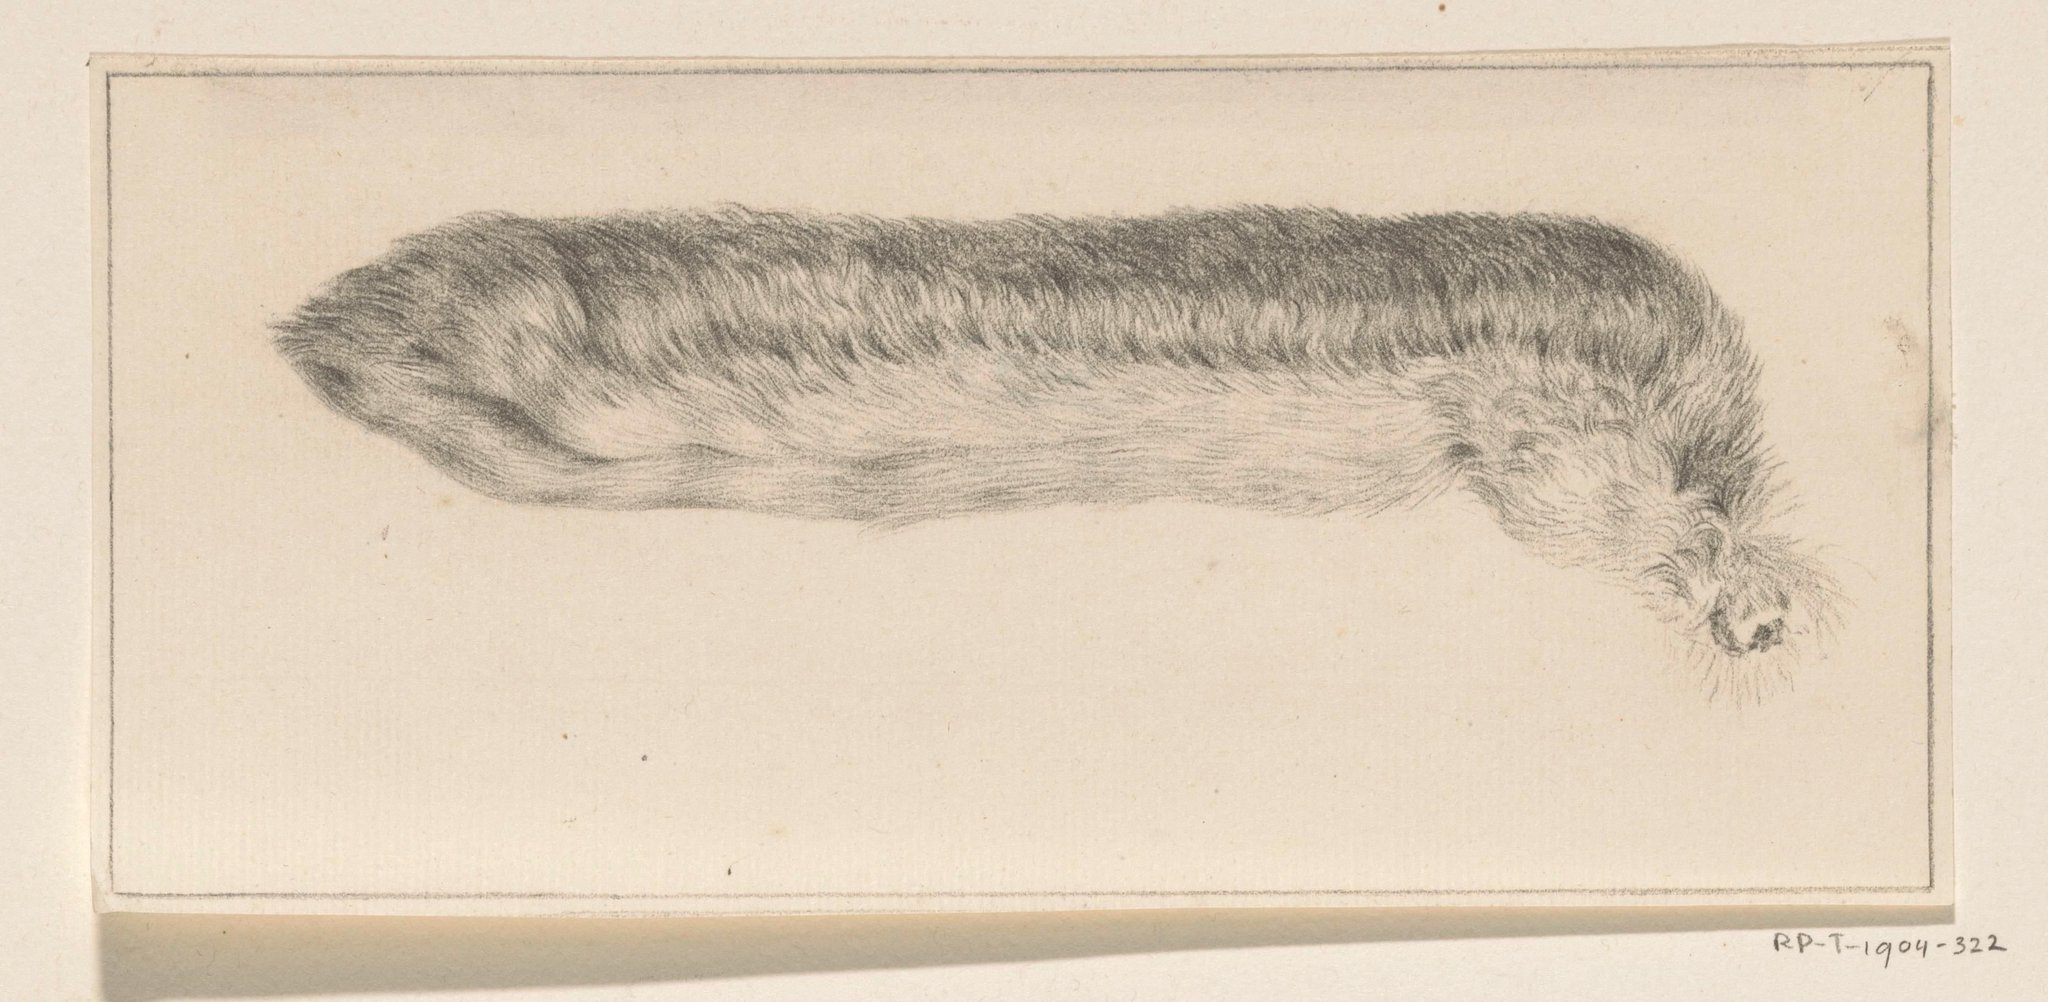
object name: drawing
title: Hazenpootje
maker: jean bernard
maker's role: draughtsman, print maker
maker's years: 1765-1833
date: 1775-1833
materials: chalk, paper, pencil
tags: rodents: rabbit (+ claws, paws of an animal), amulet, talisman